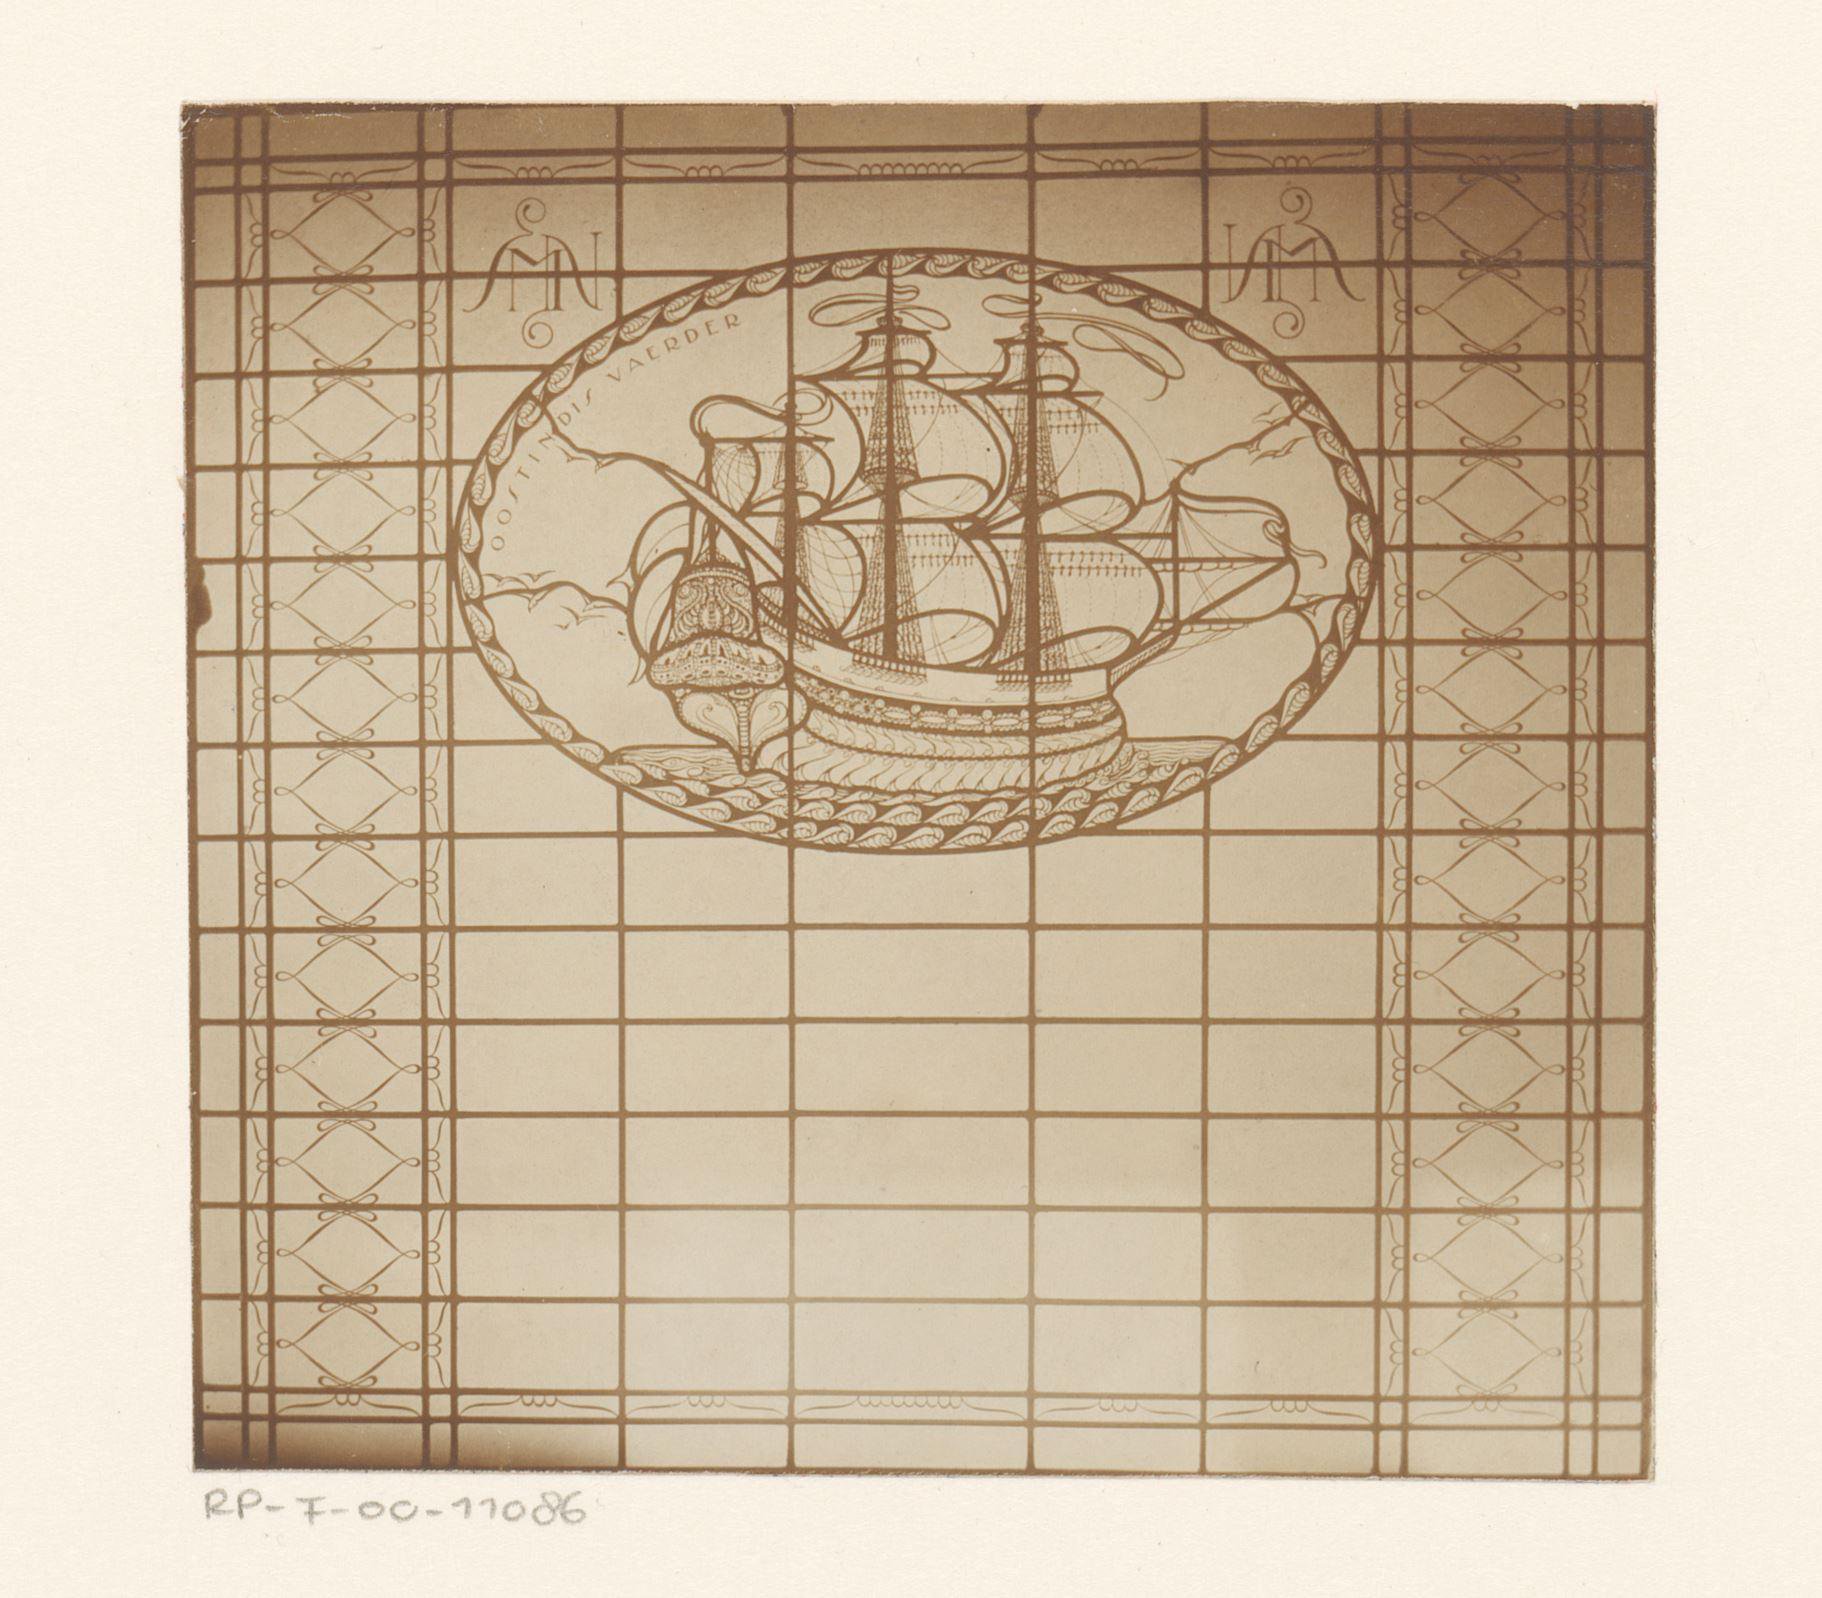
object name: photograph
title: Glas in loodraam met een Oostindië vaarder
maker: Anonymous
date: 1907-1930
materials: photographic support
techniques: collodion silver print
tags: sailing-ship, sailing-boat, work of monumental art